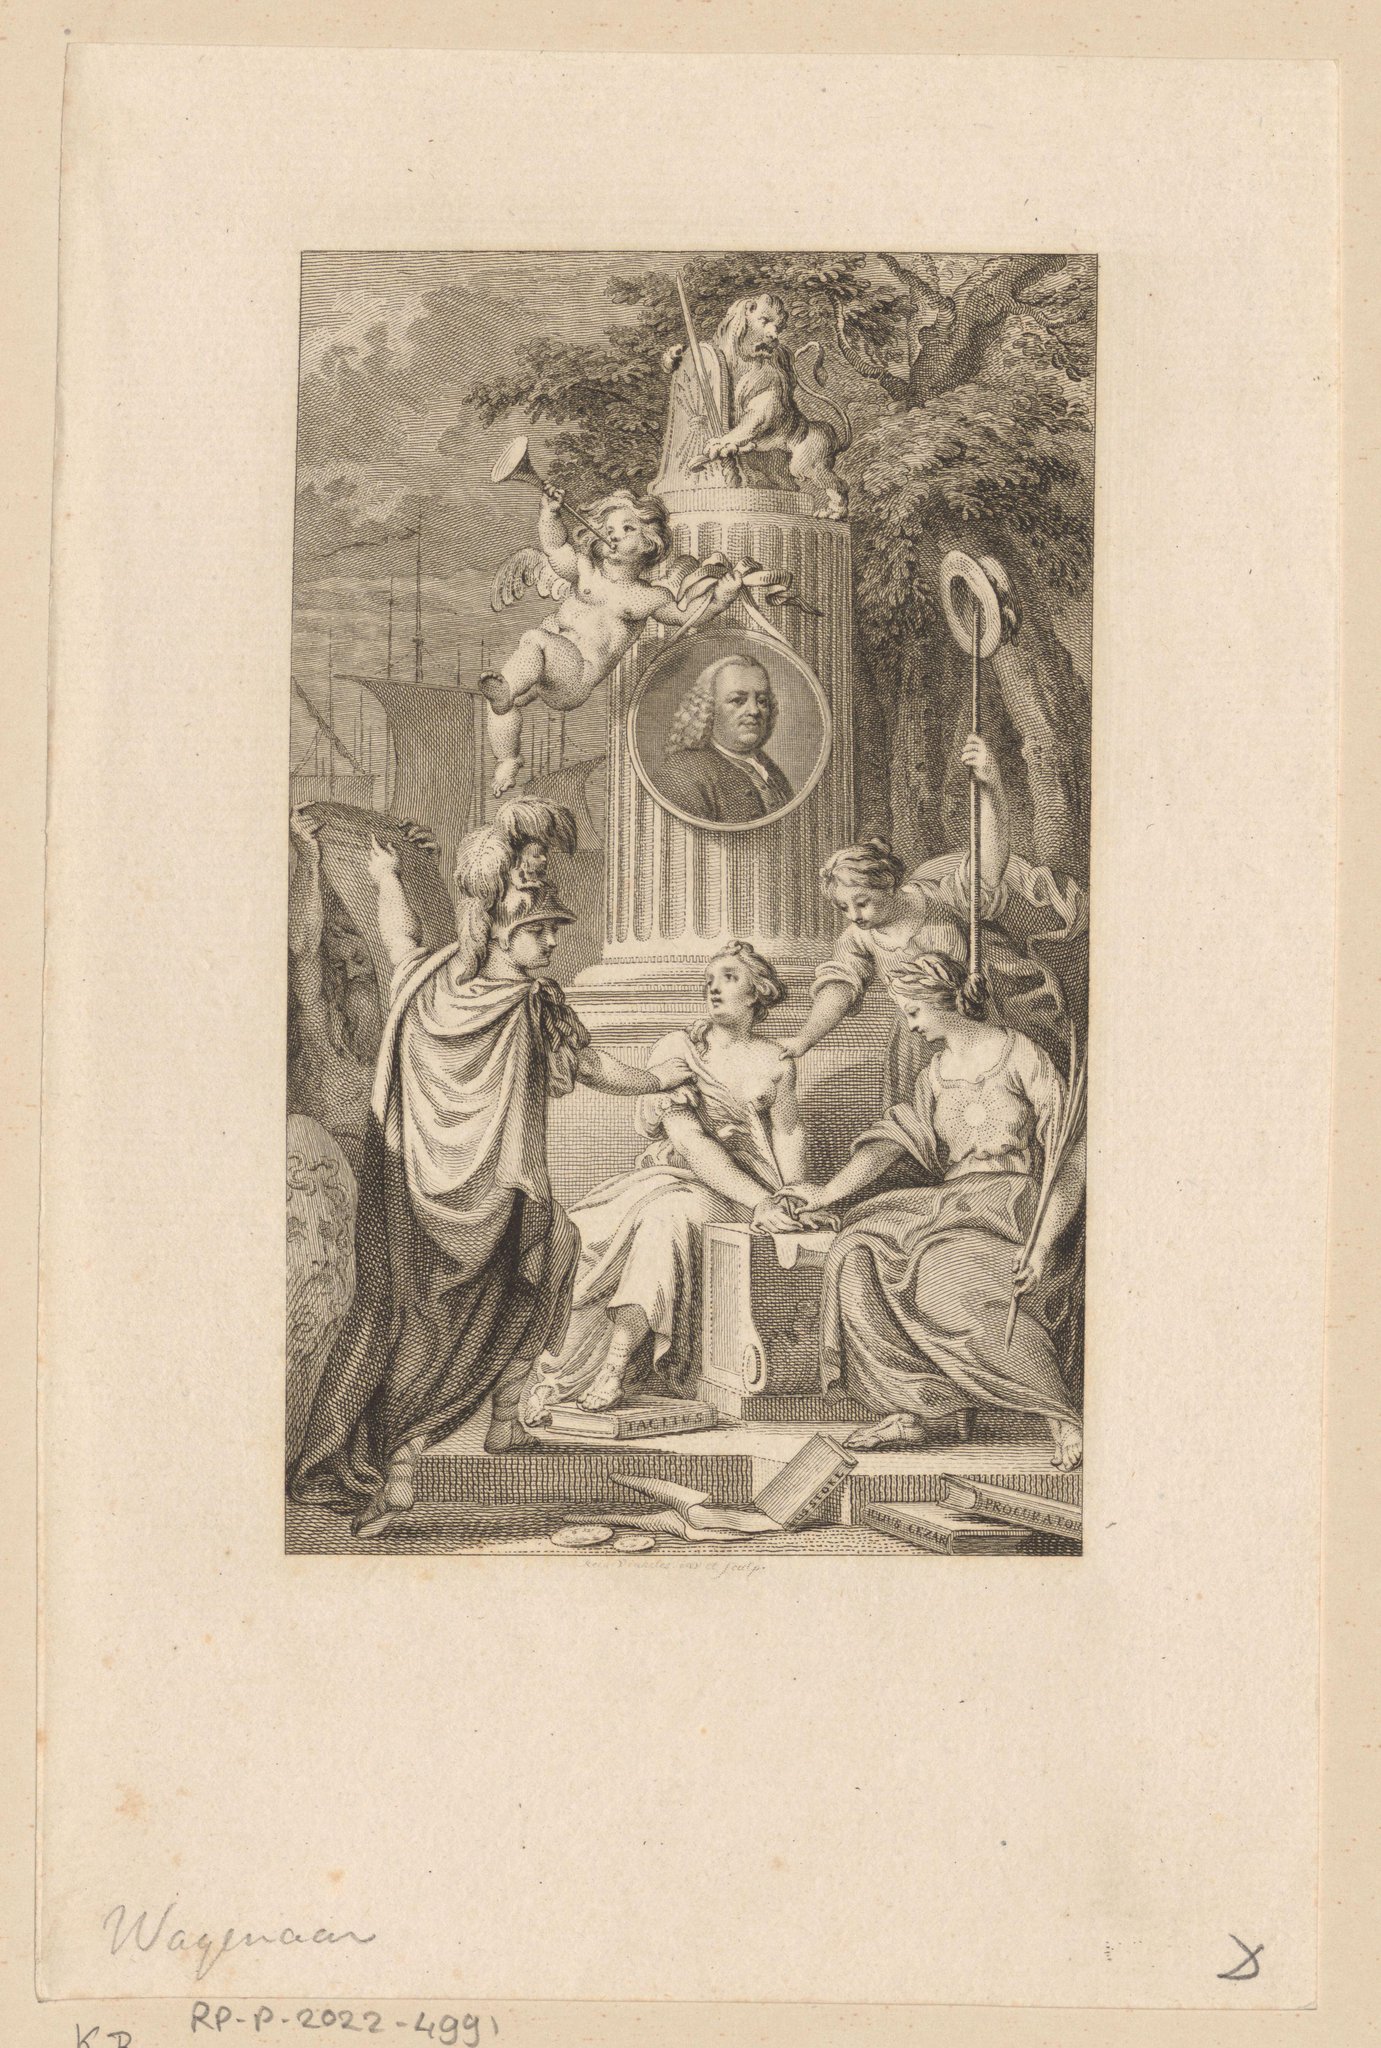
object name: titelblad, titelpagina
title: Portret van Jan Wagenaar met allegorische figuren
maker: reinier vinkeles (i)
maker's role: draughtsman, print maker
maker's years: 1741-1816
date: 1790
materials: paper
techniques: engraving, etching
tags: amsterdam, jan wagenaar, historical persons, truth; 'verità' (ripa), book, 'historia'; 'historia' (ripa), freedom, liberty; 'libertà' (ripa), cupids: 'amores', 'amoretti', 'putti'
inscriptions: collector's mark: Lugt 240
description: Prent waarschijnlijk uit: Wagenaar, Jan. Vaderlandsche historie (...). Amsterdam: J. Allart, 1790, dl. 1, tweede druk.